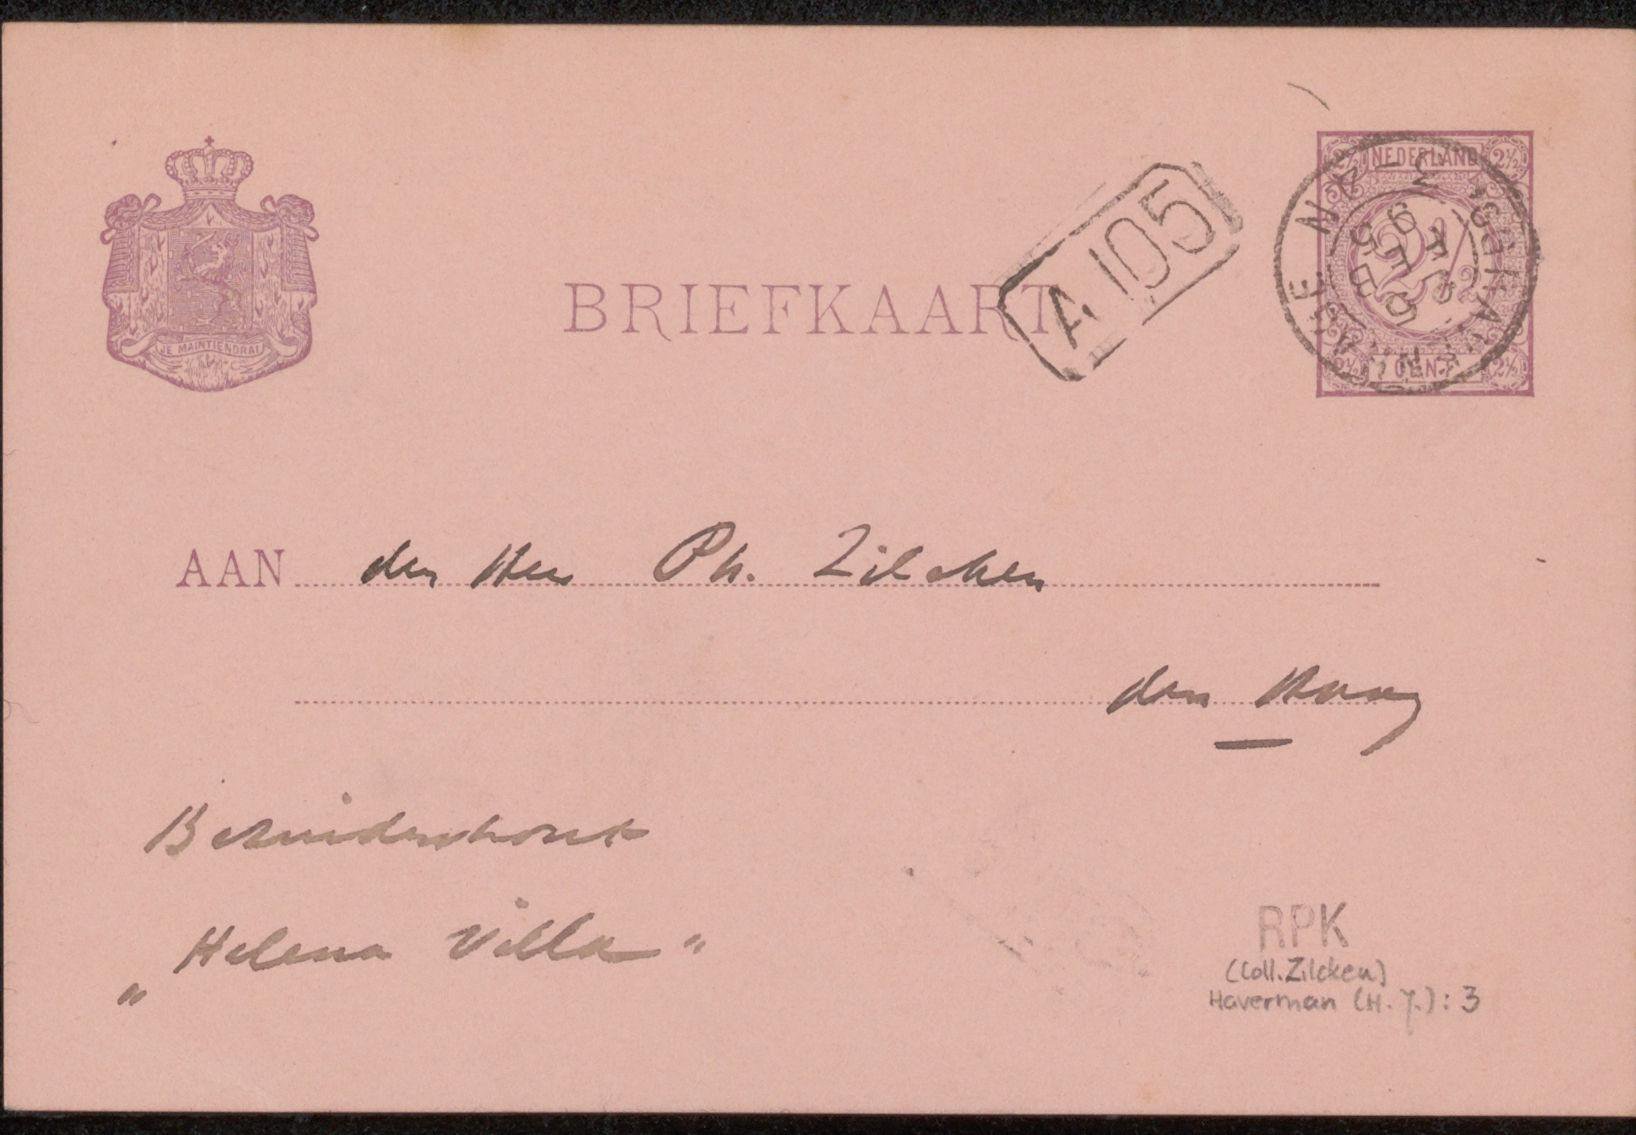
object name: postcard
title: Briefkaart aan Philip Zilcken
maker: hendrik johannes haverman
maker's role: draughtsman, print maker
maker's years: 1857-1928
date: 1895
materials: cardboard, ink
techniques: pen, writing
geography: the hague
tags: painter, philip zilcken, family life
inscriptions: collector's mark: ‘RPK’